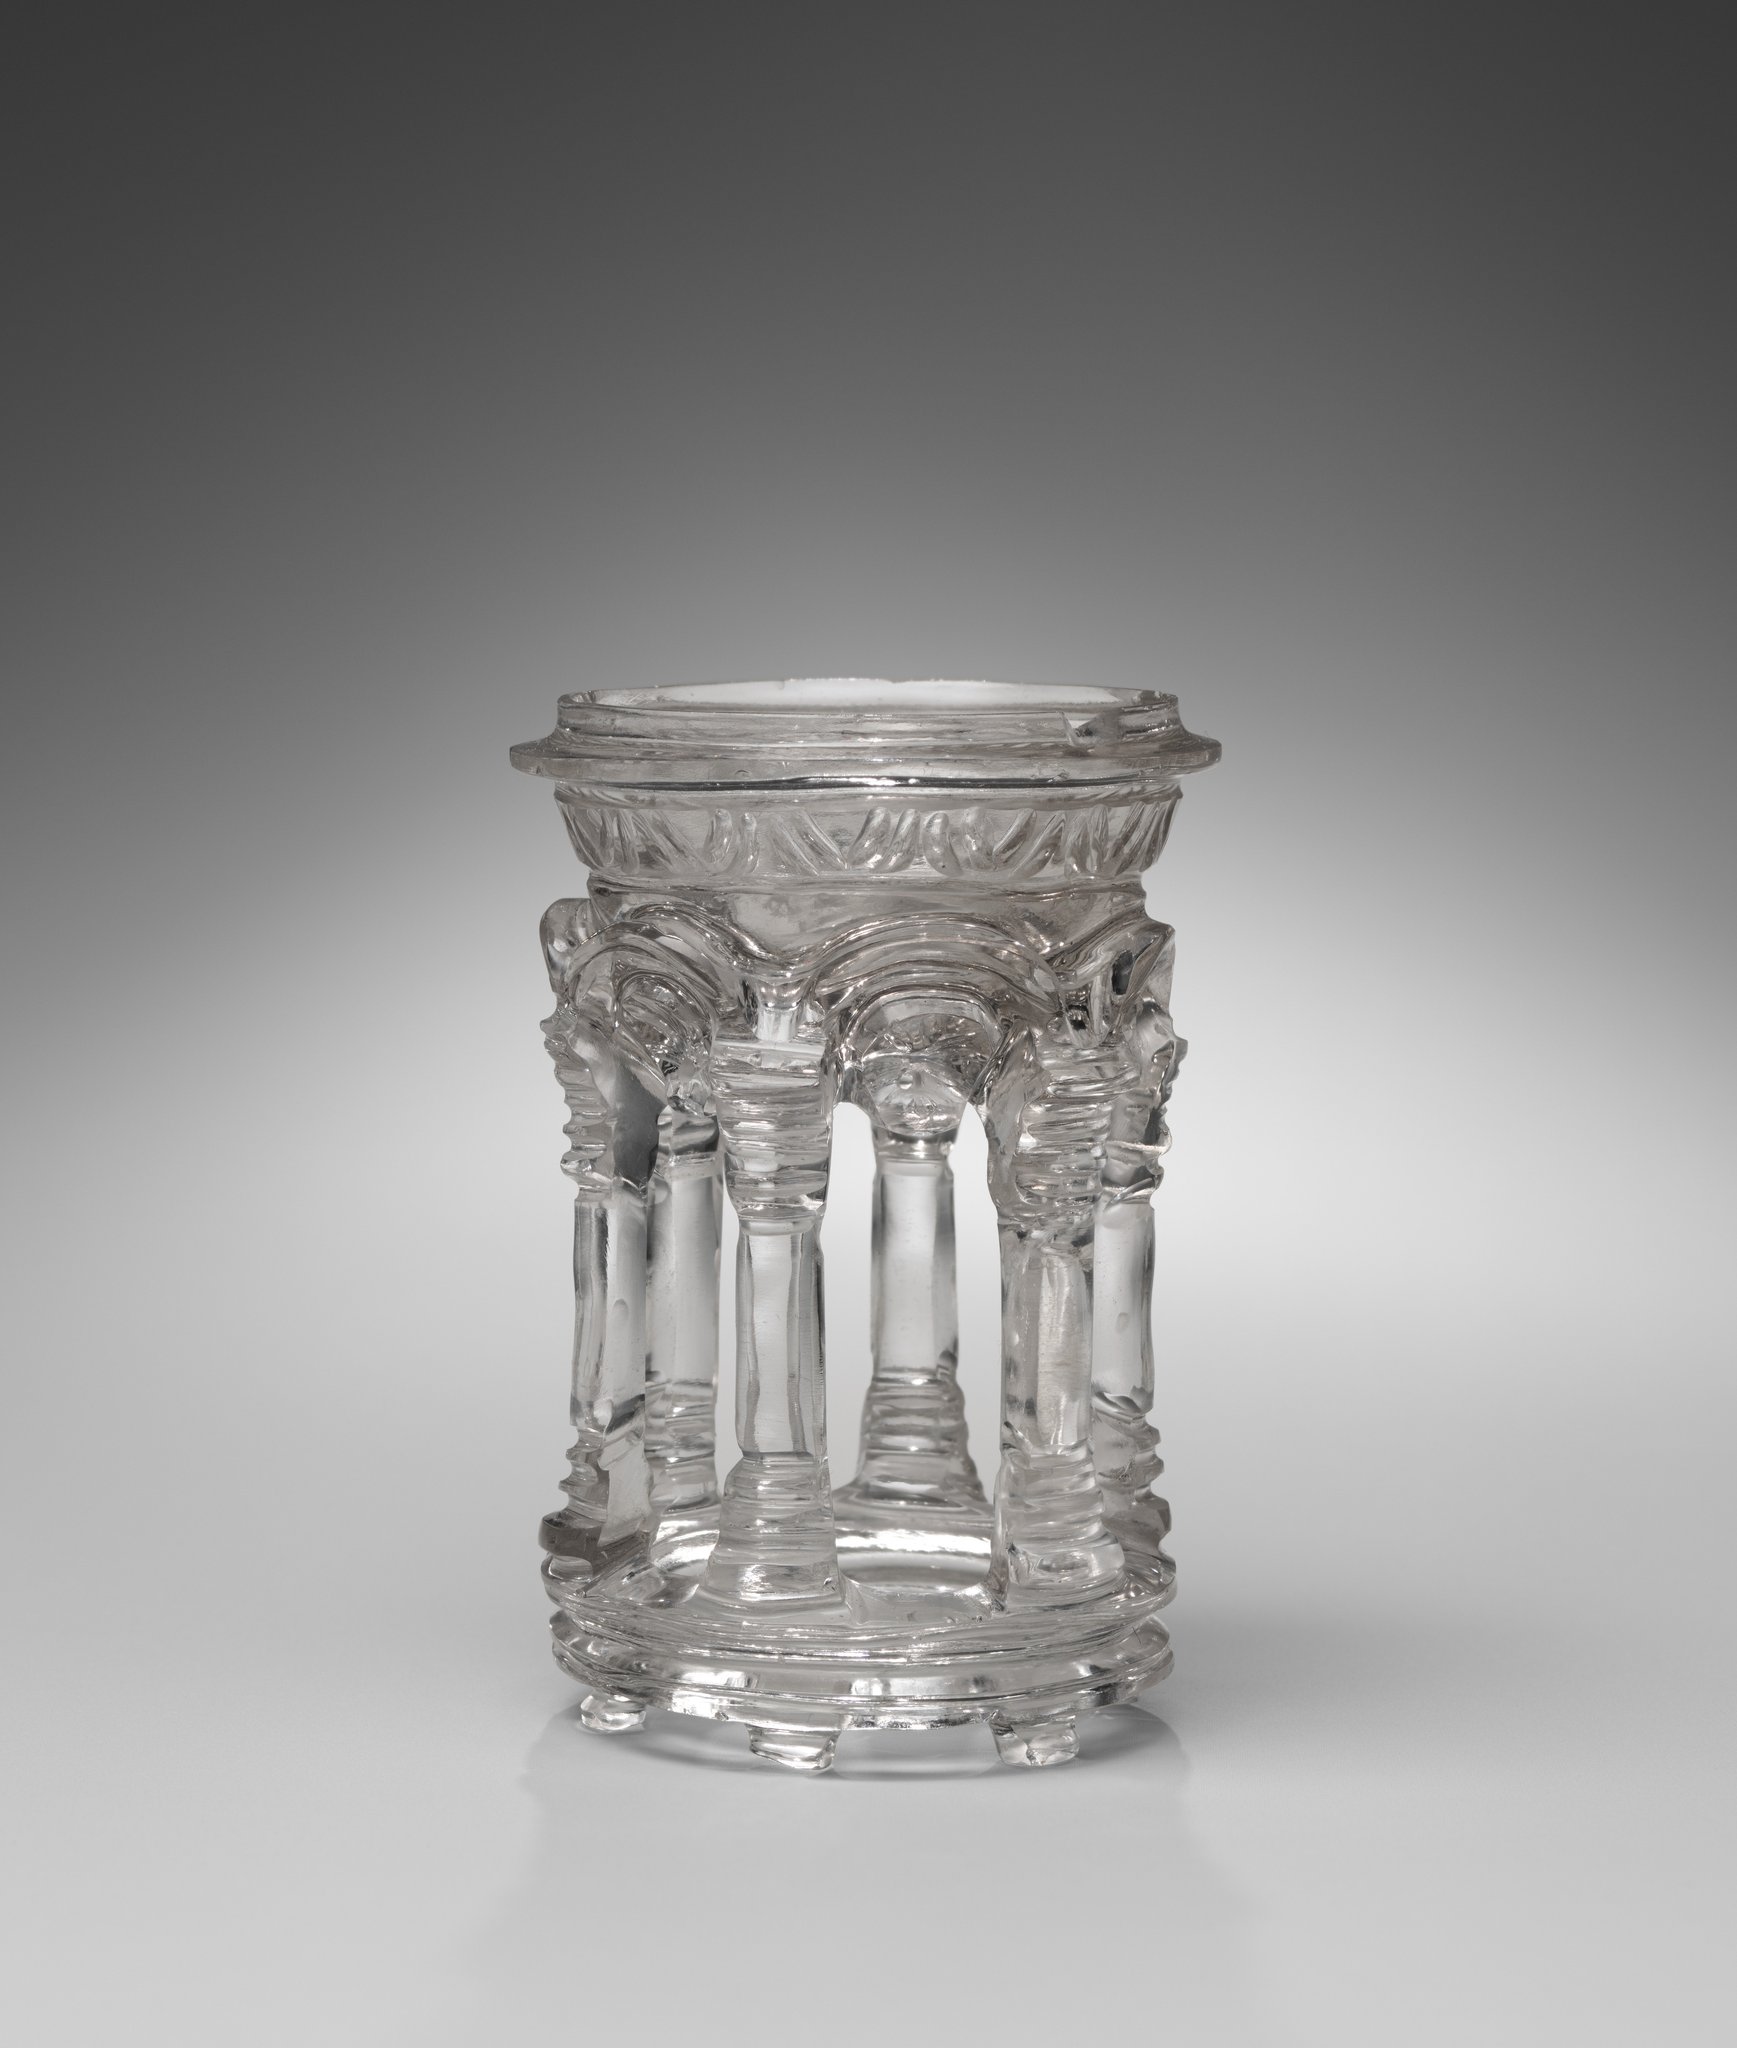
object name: dish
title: Rock Crystal Dish in the Form of a Temple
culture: north african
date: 201-500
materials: quartz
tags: temples